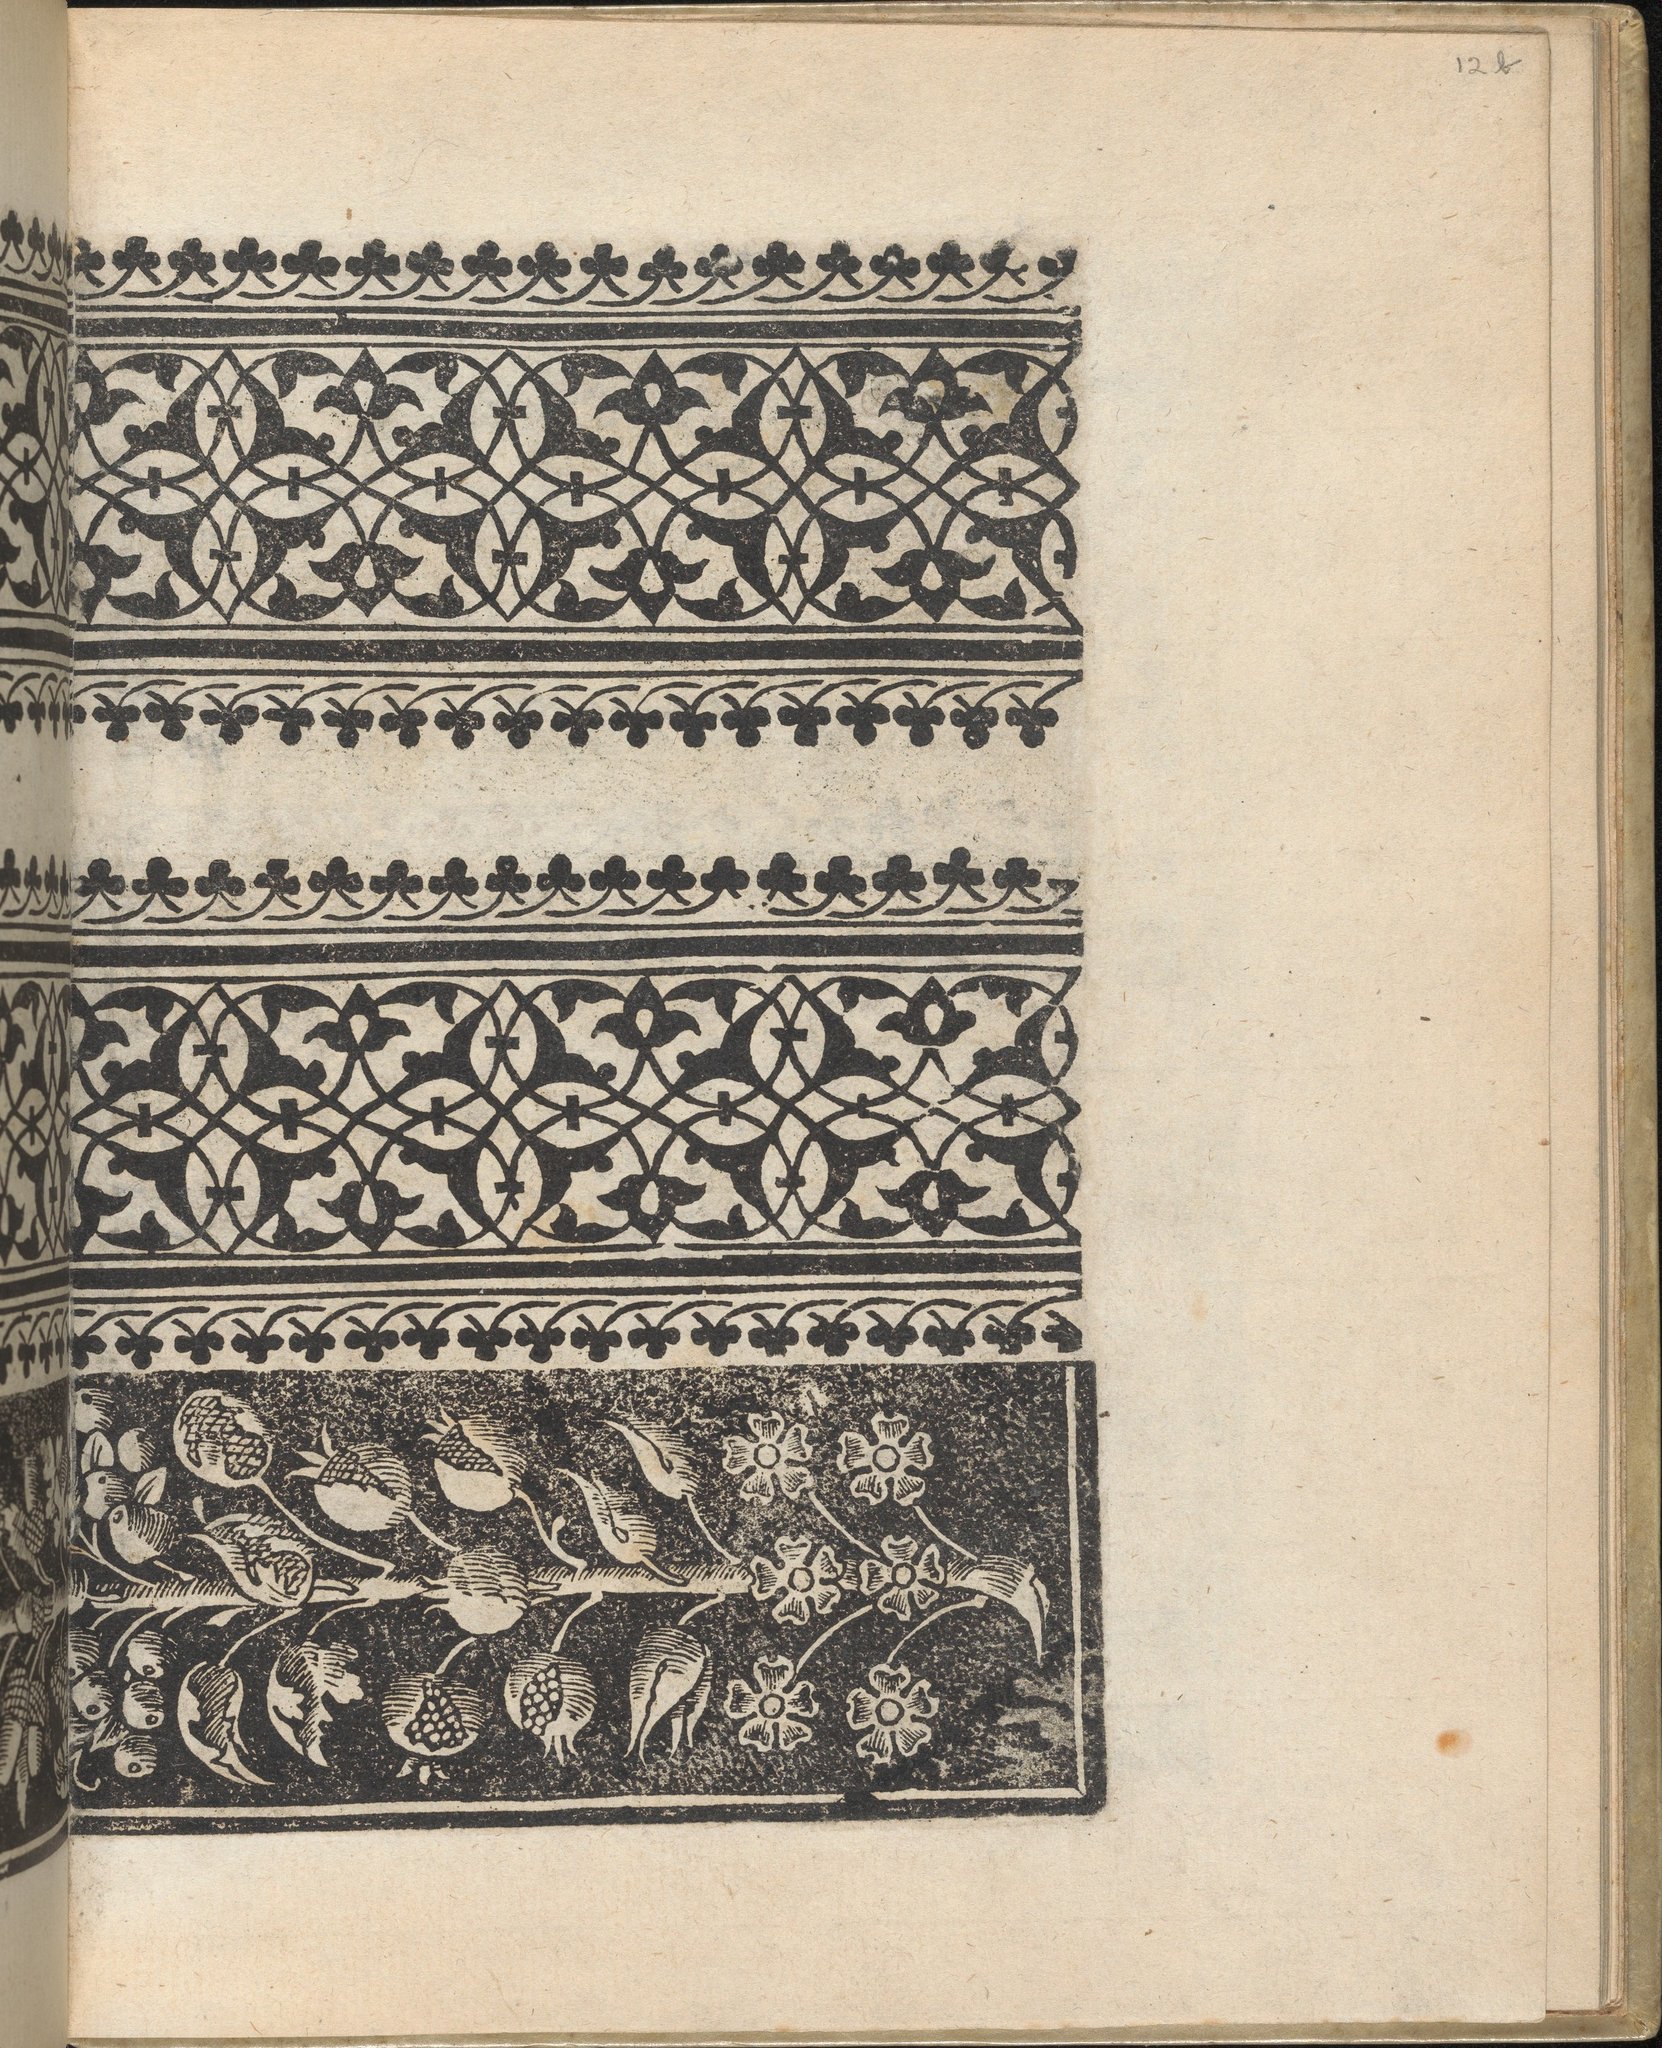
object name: book print ornament architecture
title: Trionfo Di Virtu. Libro Novo..., page 12 (verso)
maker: matteo pagano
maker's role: publisher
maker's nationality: italian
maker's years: 1515-1588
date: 1563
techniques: woodcut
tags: fruit,flowers